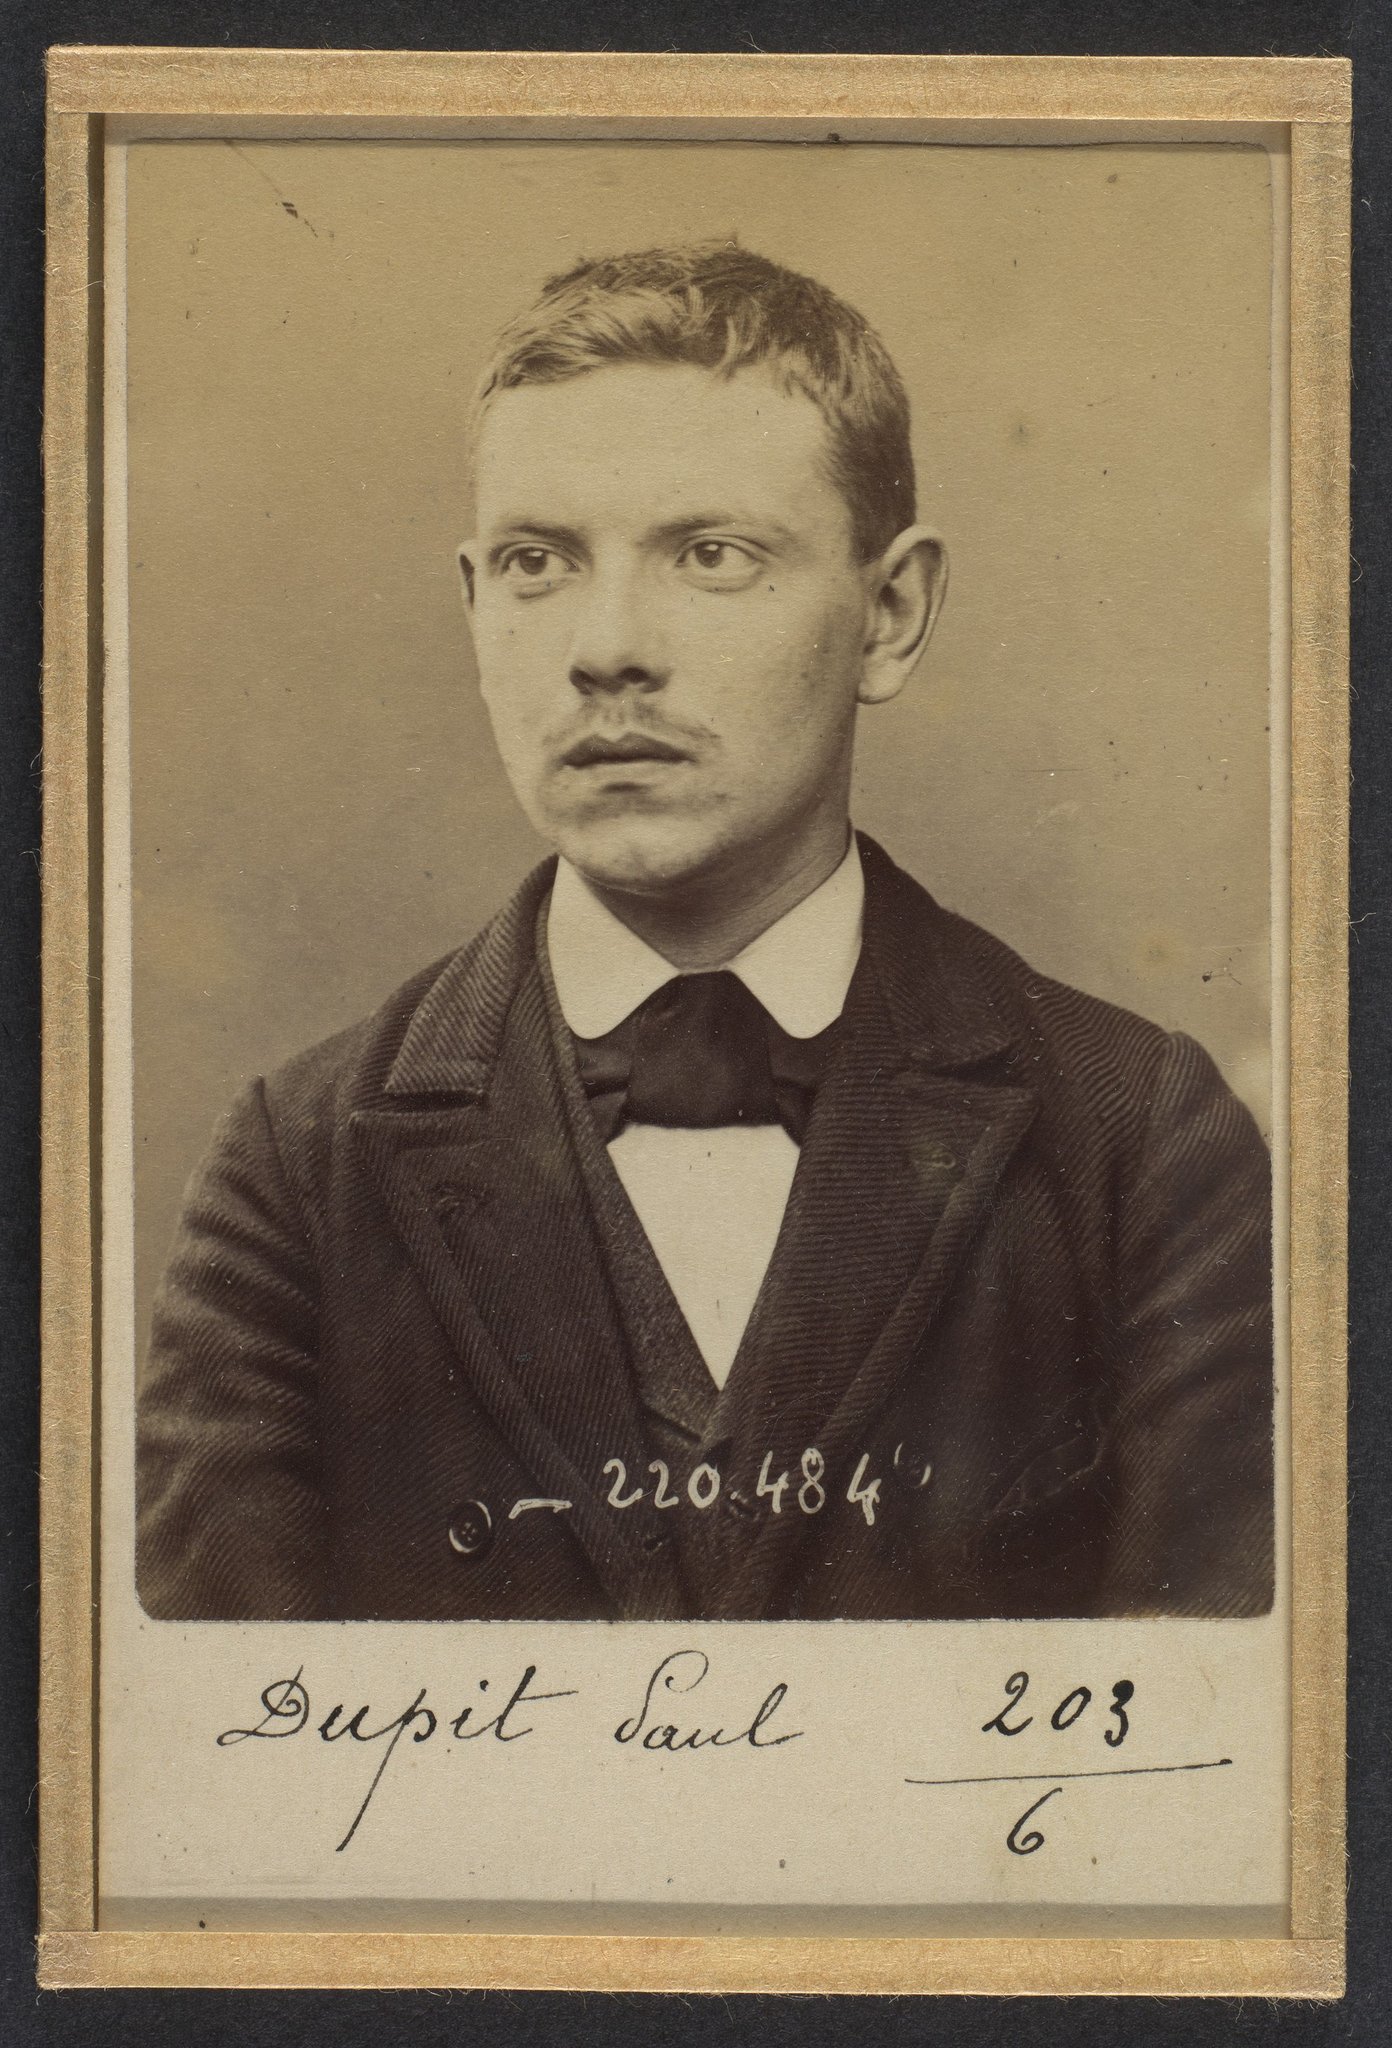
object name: mugshot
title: Dupit. Paul. 20 ans, né le 13/3/74 à Paris XVIIe. Garçon boucher. Anarchiste. 2/7/94.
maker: alphonse bertillon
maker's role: artist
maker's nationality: french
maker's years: 1853-1914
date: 1894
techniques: albumen silver print, glass negative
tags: men,portraits